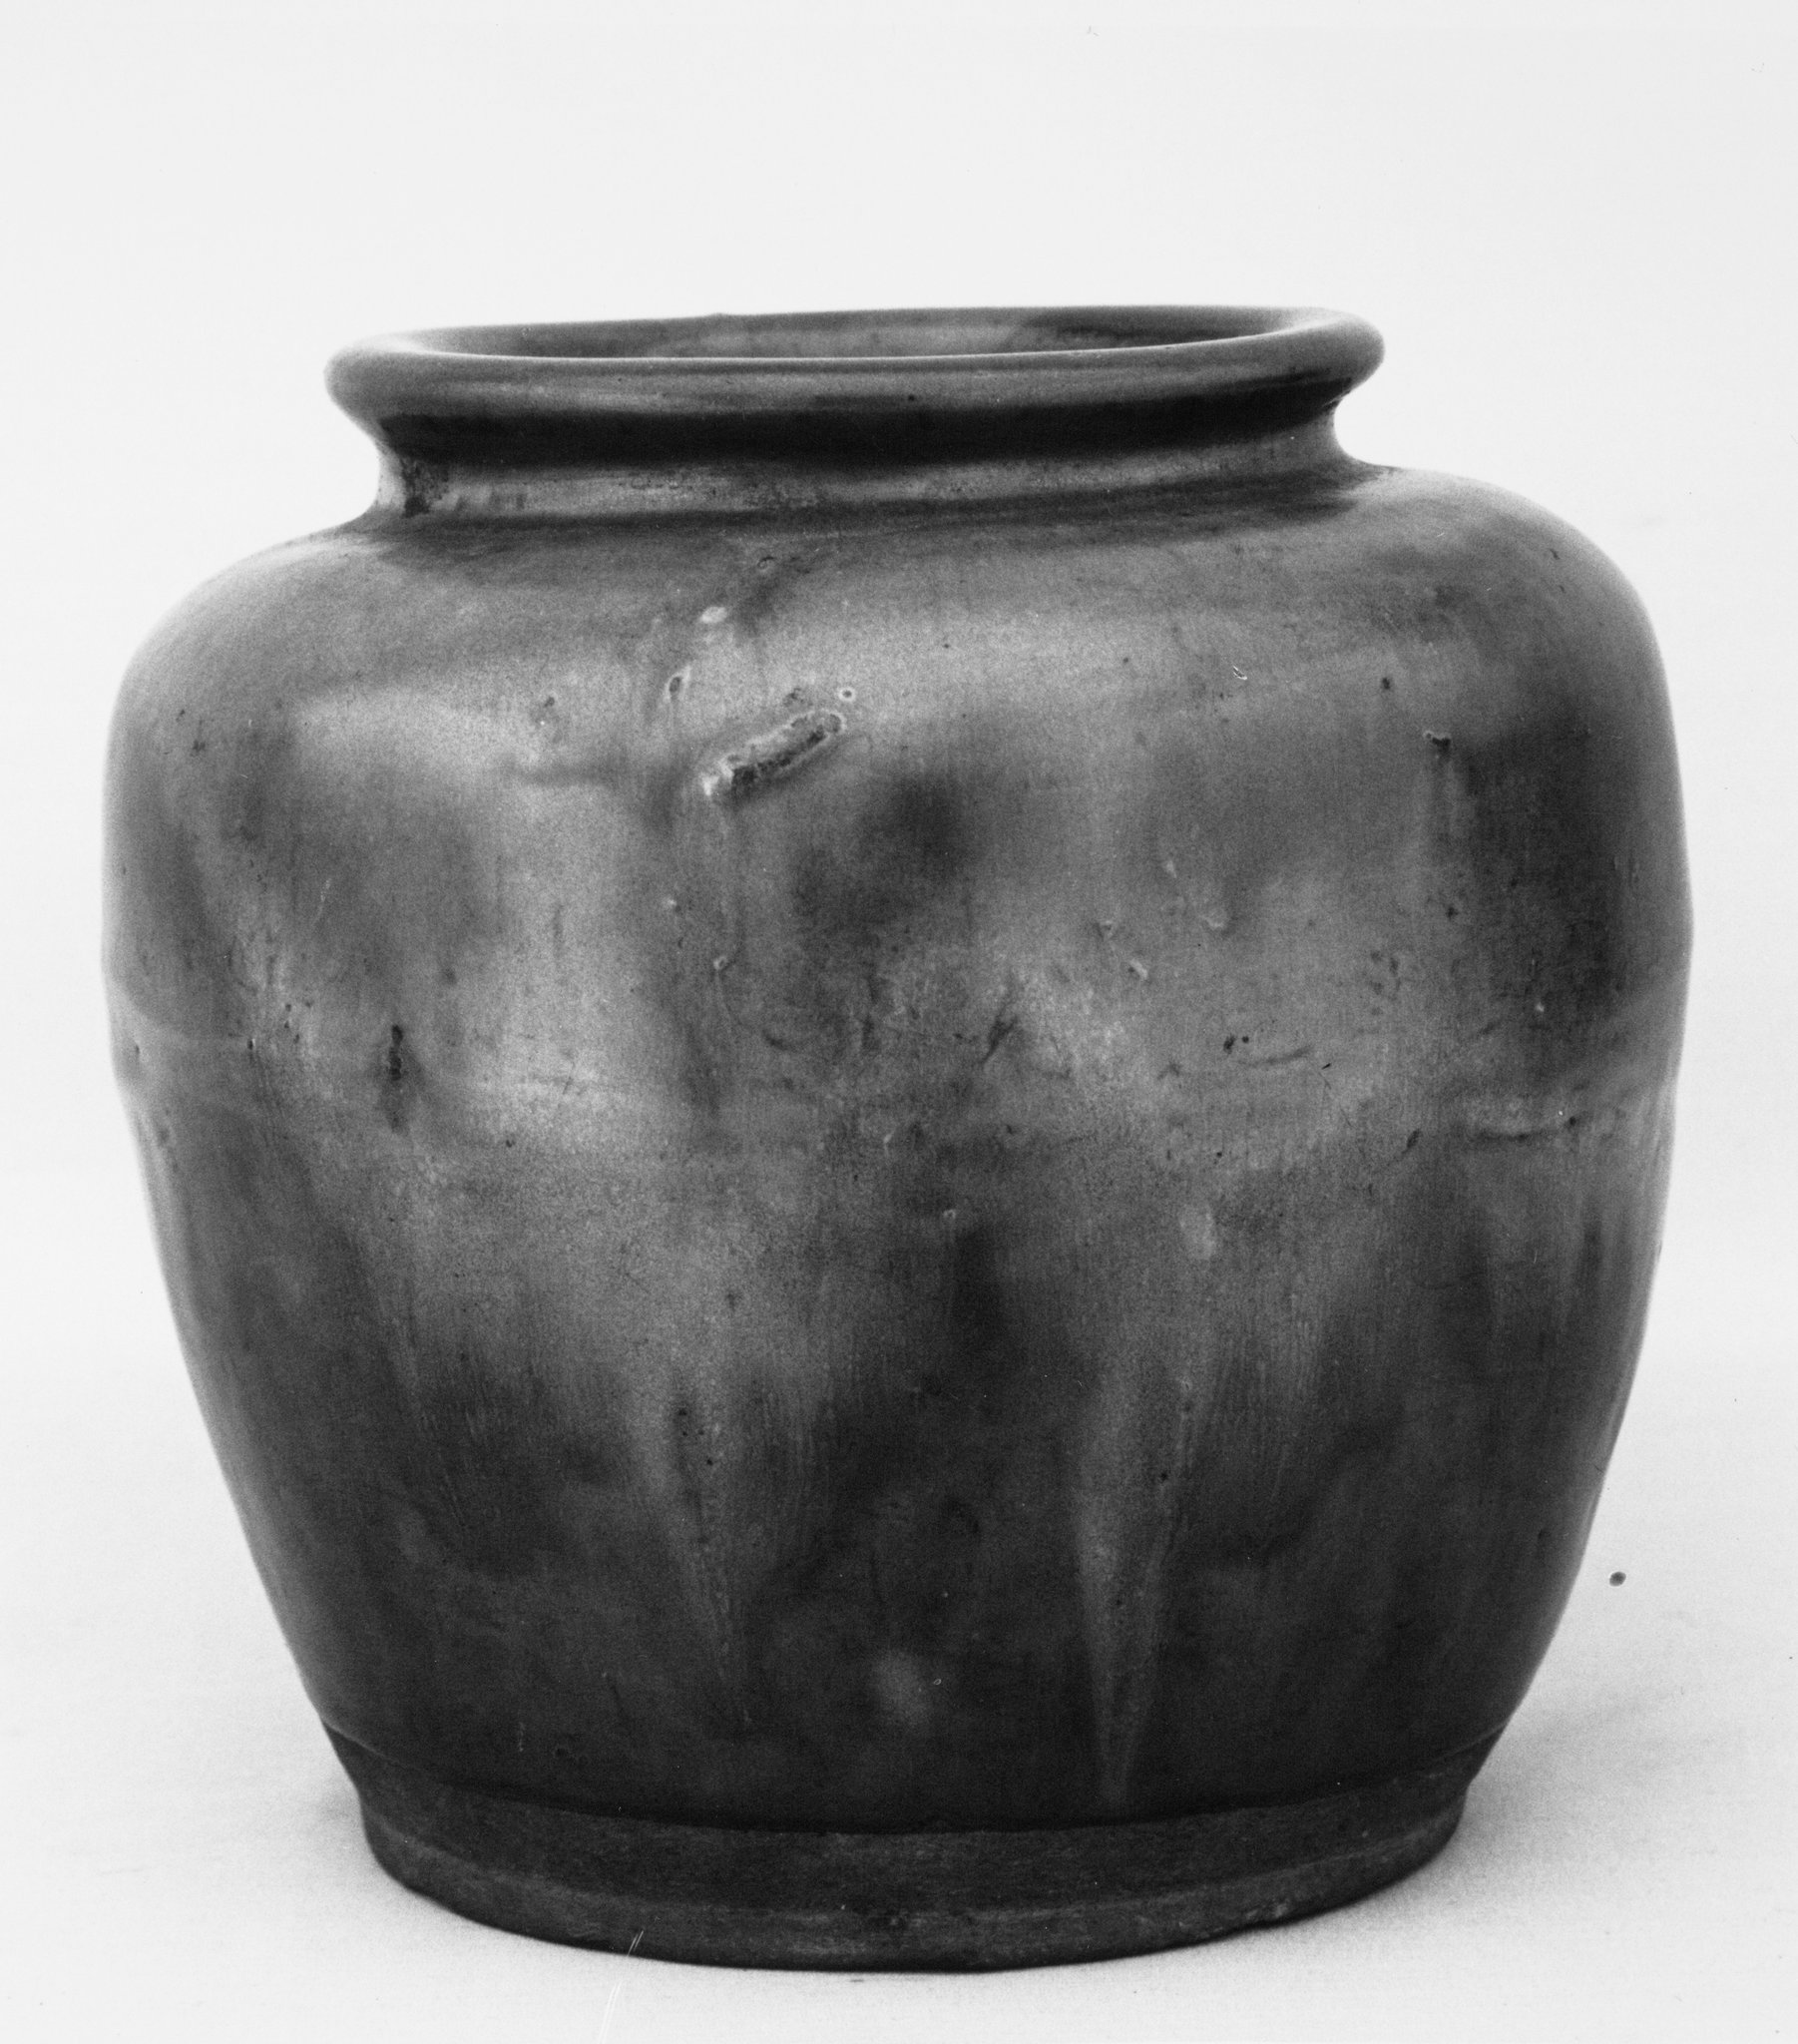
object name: water jar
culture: japanese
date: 1701-1800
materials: clay, glaze